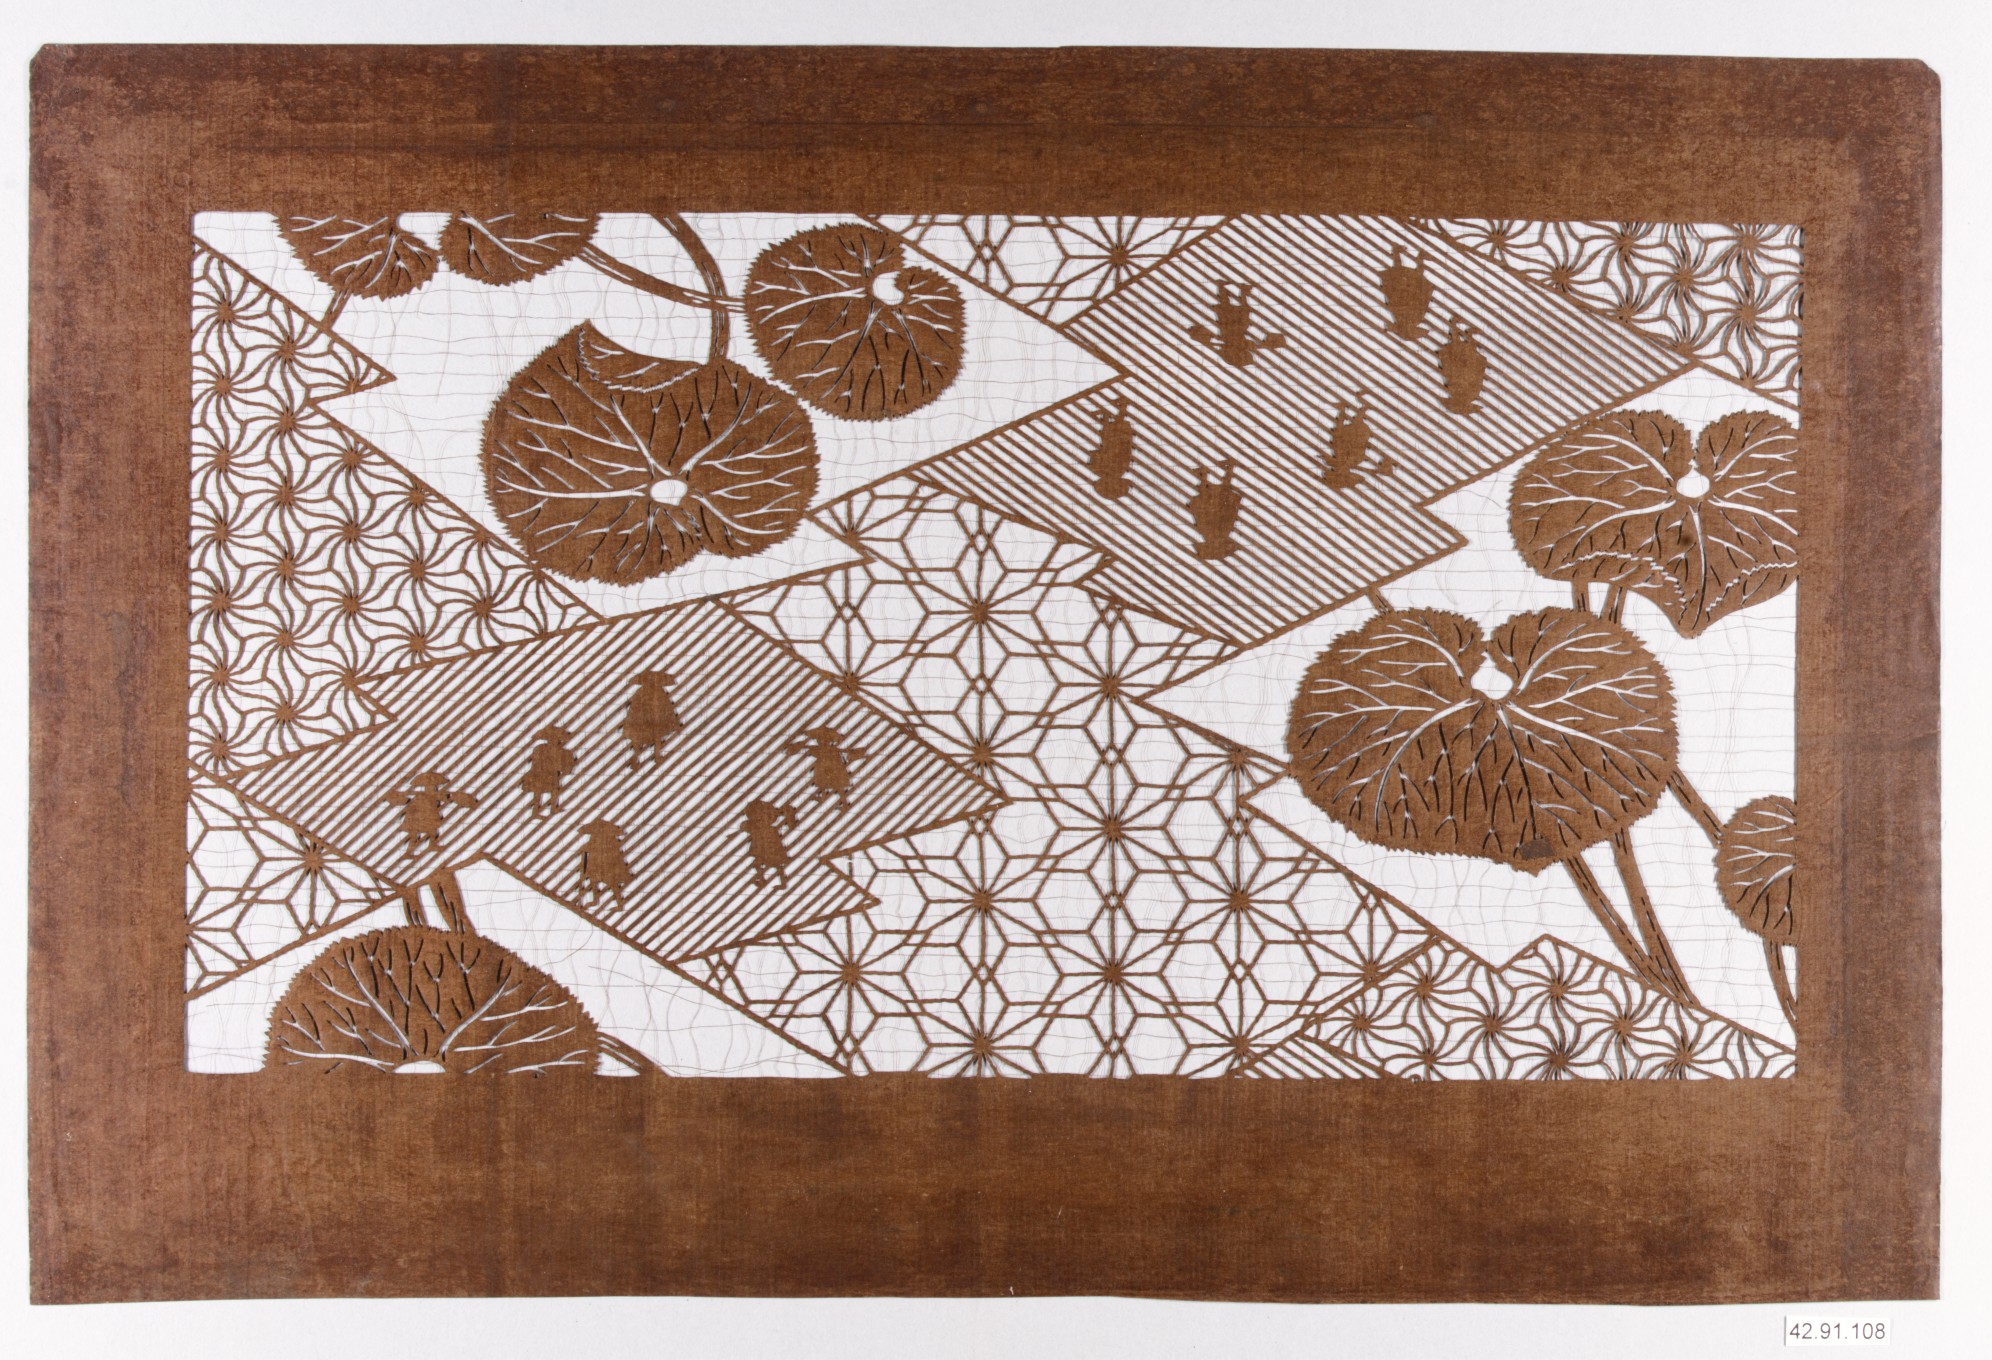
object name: stencil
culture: japanese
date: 1801-1900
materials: paper, silk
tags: human figures,leaves